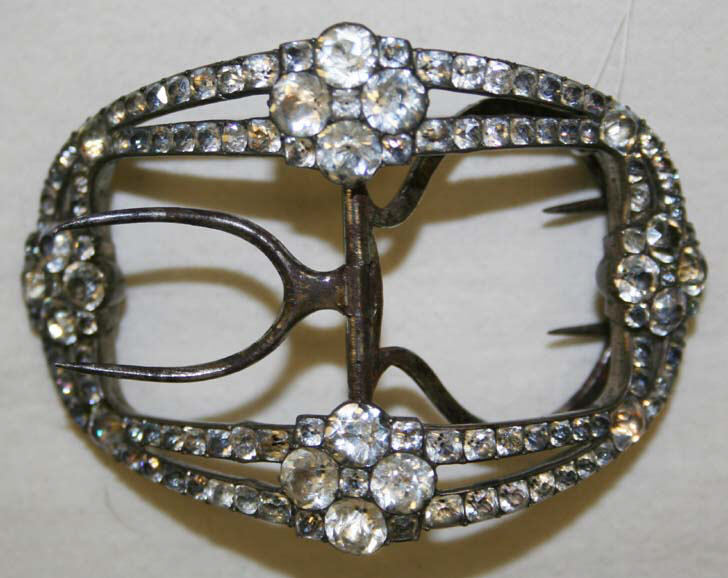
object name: shoe buckle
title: Shoe buckles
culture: french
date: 1767-1800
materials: metal